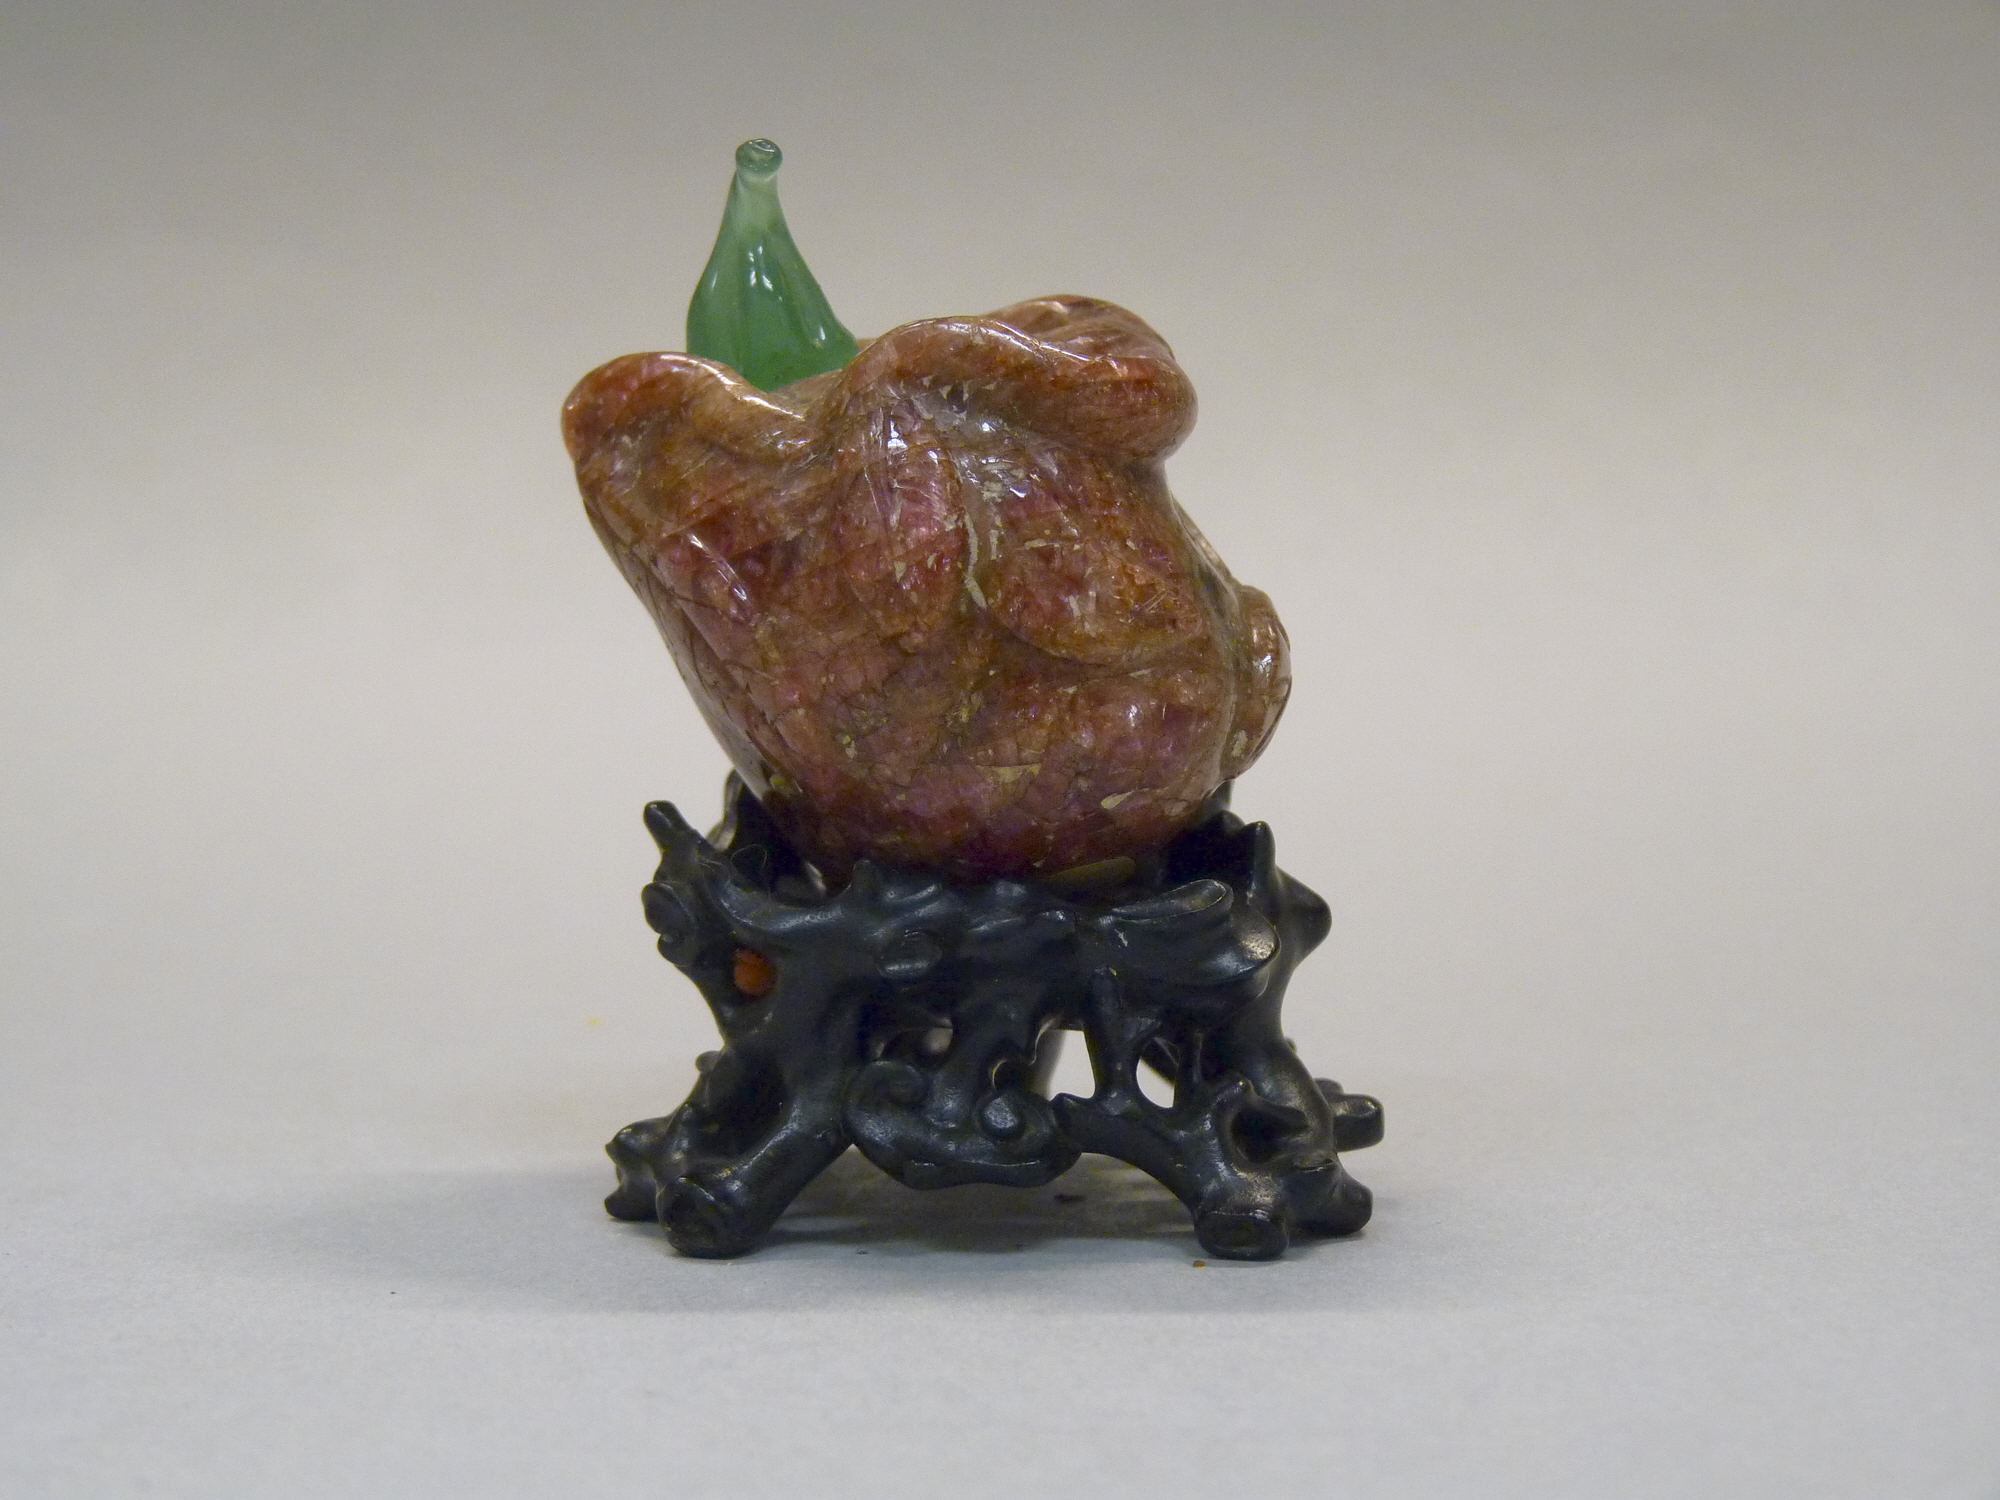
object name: snuff bottle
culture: chinese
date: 1736-1795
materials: glass, gemstone